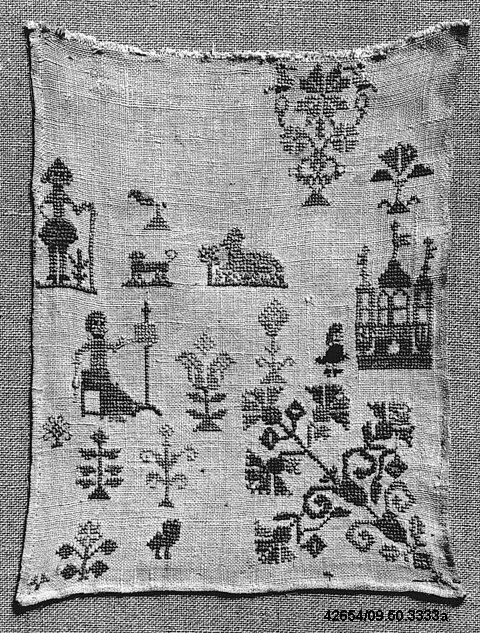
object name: sampler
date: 1701-1800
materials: linen, silk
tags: human figures,buildings,plants